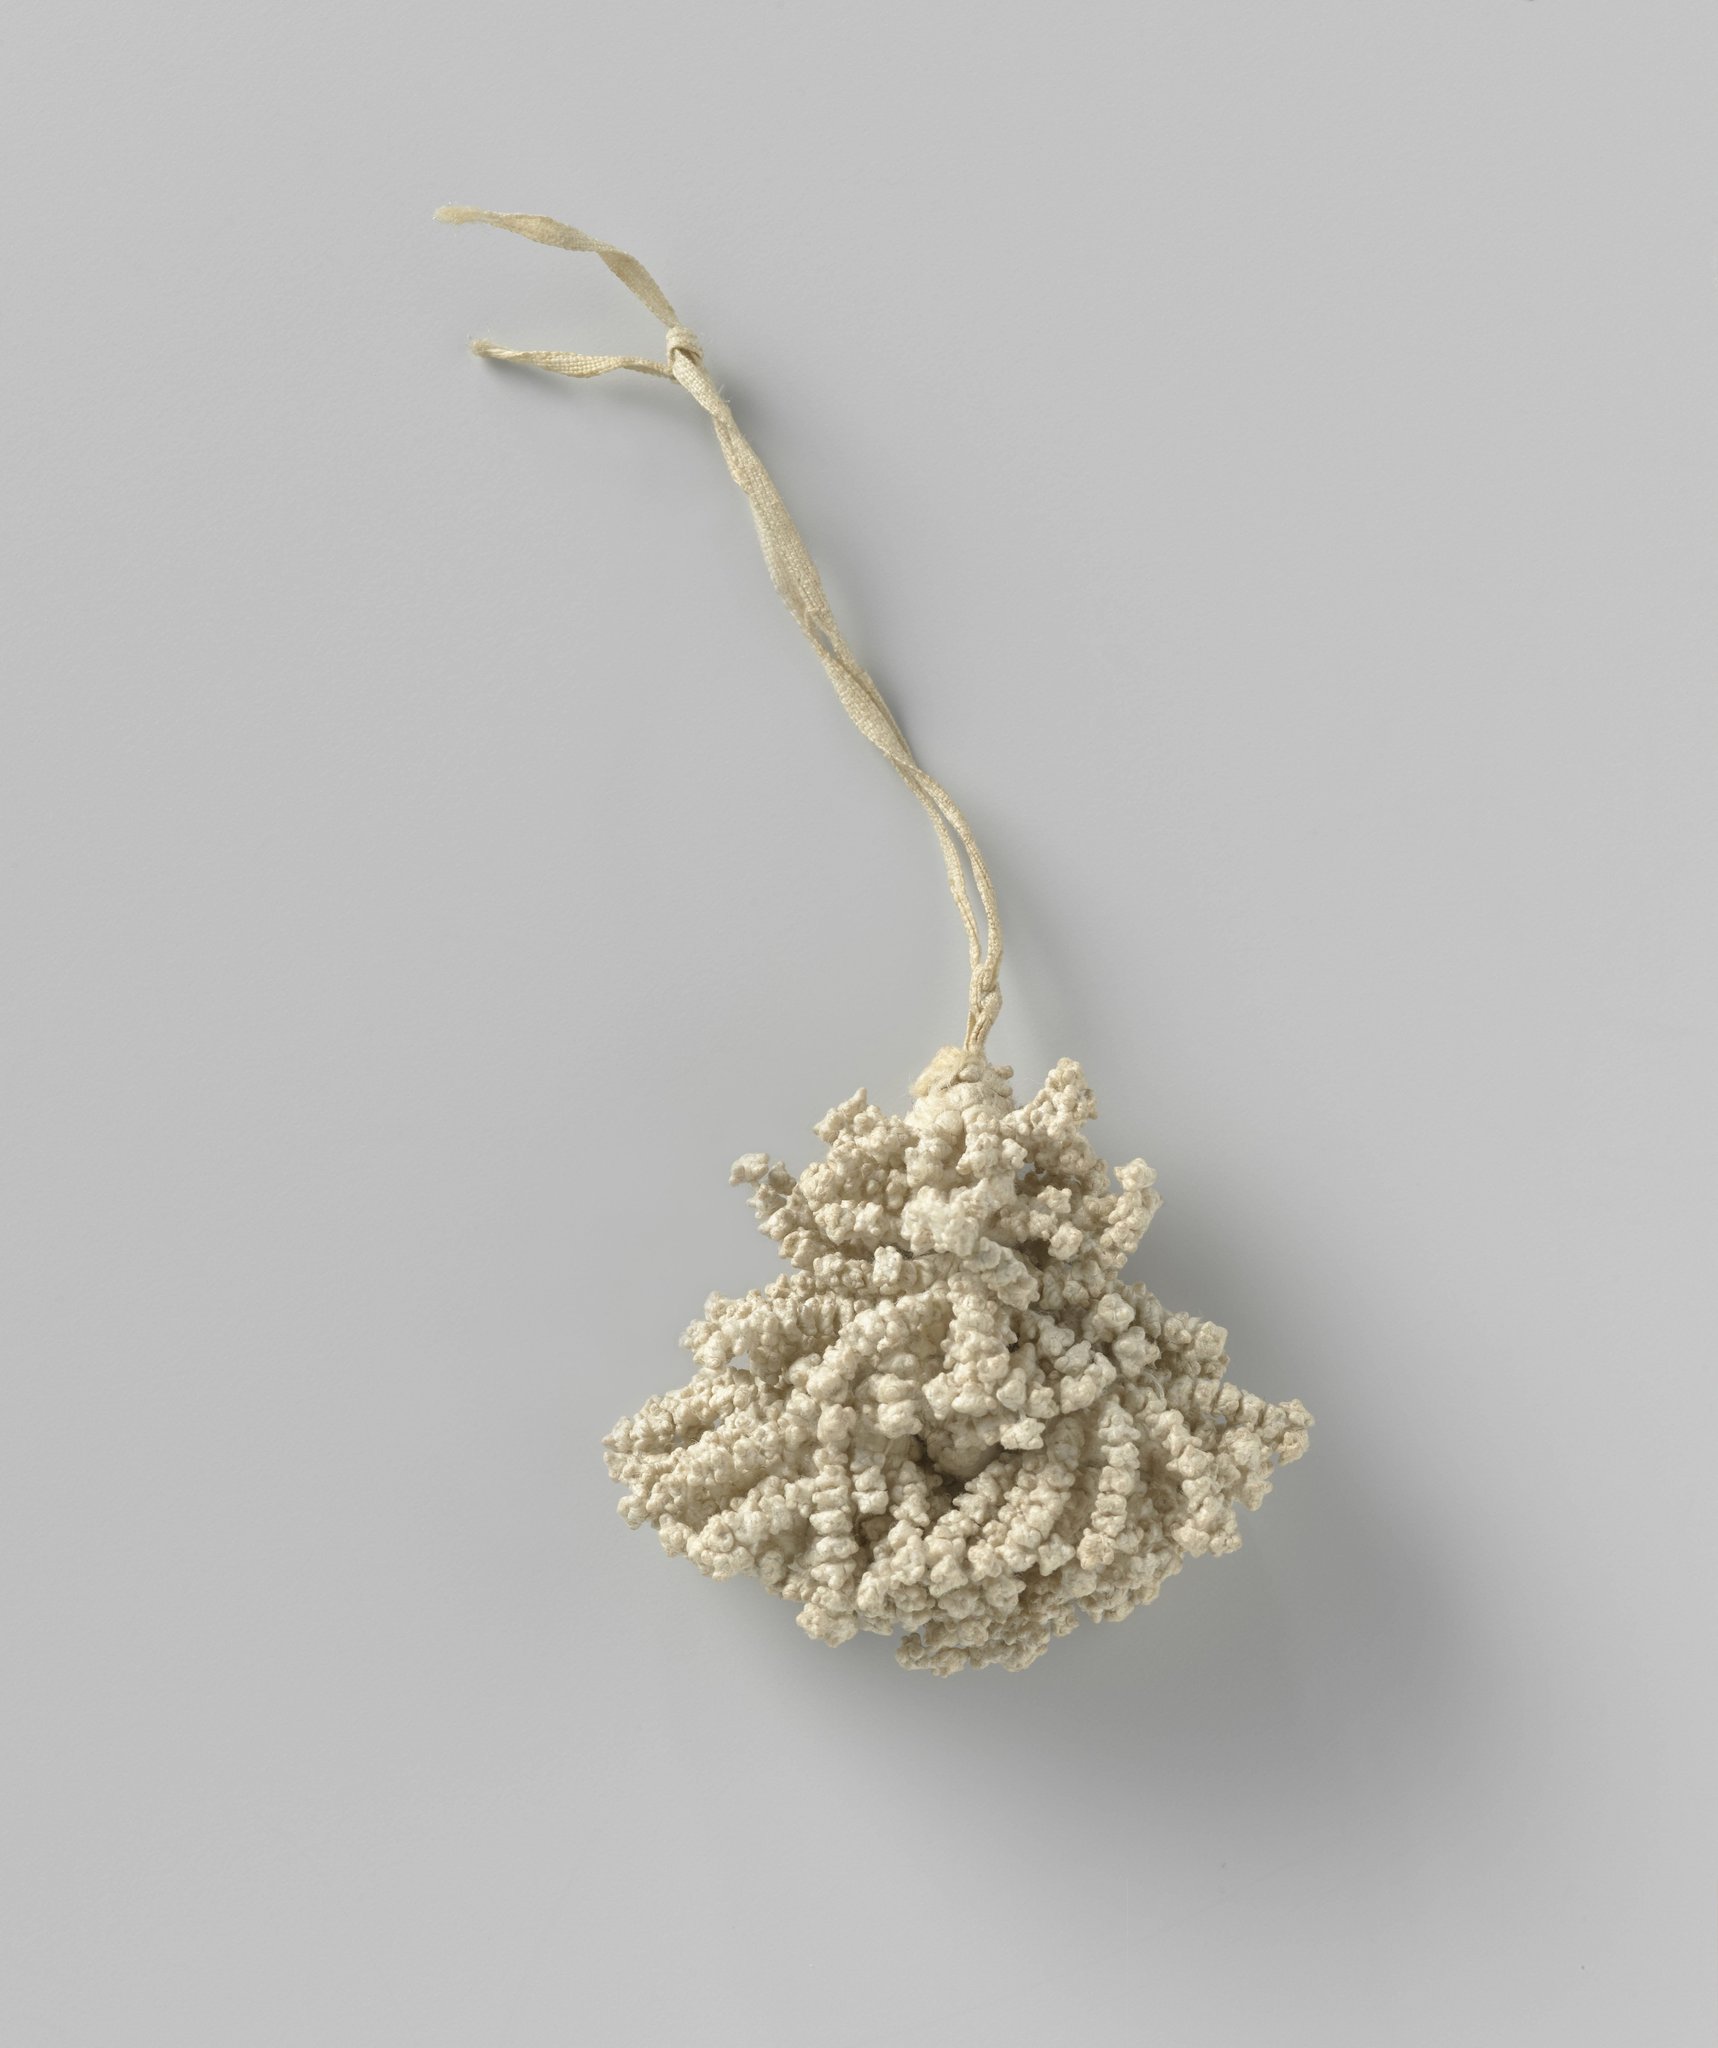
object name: miniature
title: Aker of kwast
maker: Anonymous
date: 1625-1700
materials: linen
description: Aker of sierkwast, behorende bij vijftien akers of sierkwasten, waaronder drie paar vastgenaaid of geknoopt aan koordjes met ronde platbinding. De kwasten zijn verschillend van formaat en vervaardigd van linnen draad dat in talloze strengen van knoopjes is gestrikt en met een stijfselpap is verstevigd. De kwasten zijn samengesteld uit meerdere lagen van "bundels" met strengen knoopjes. BK-NM-5448-5-A t/m O.